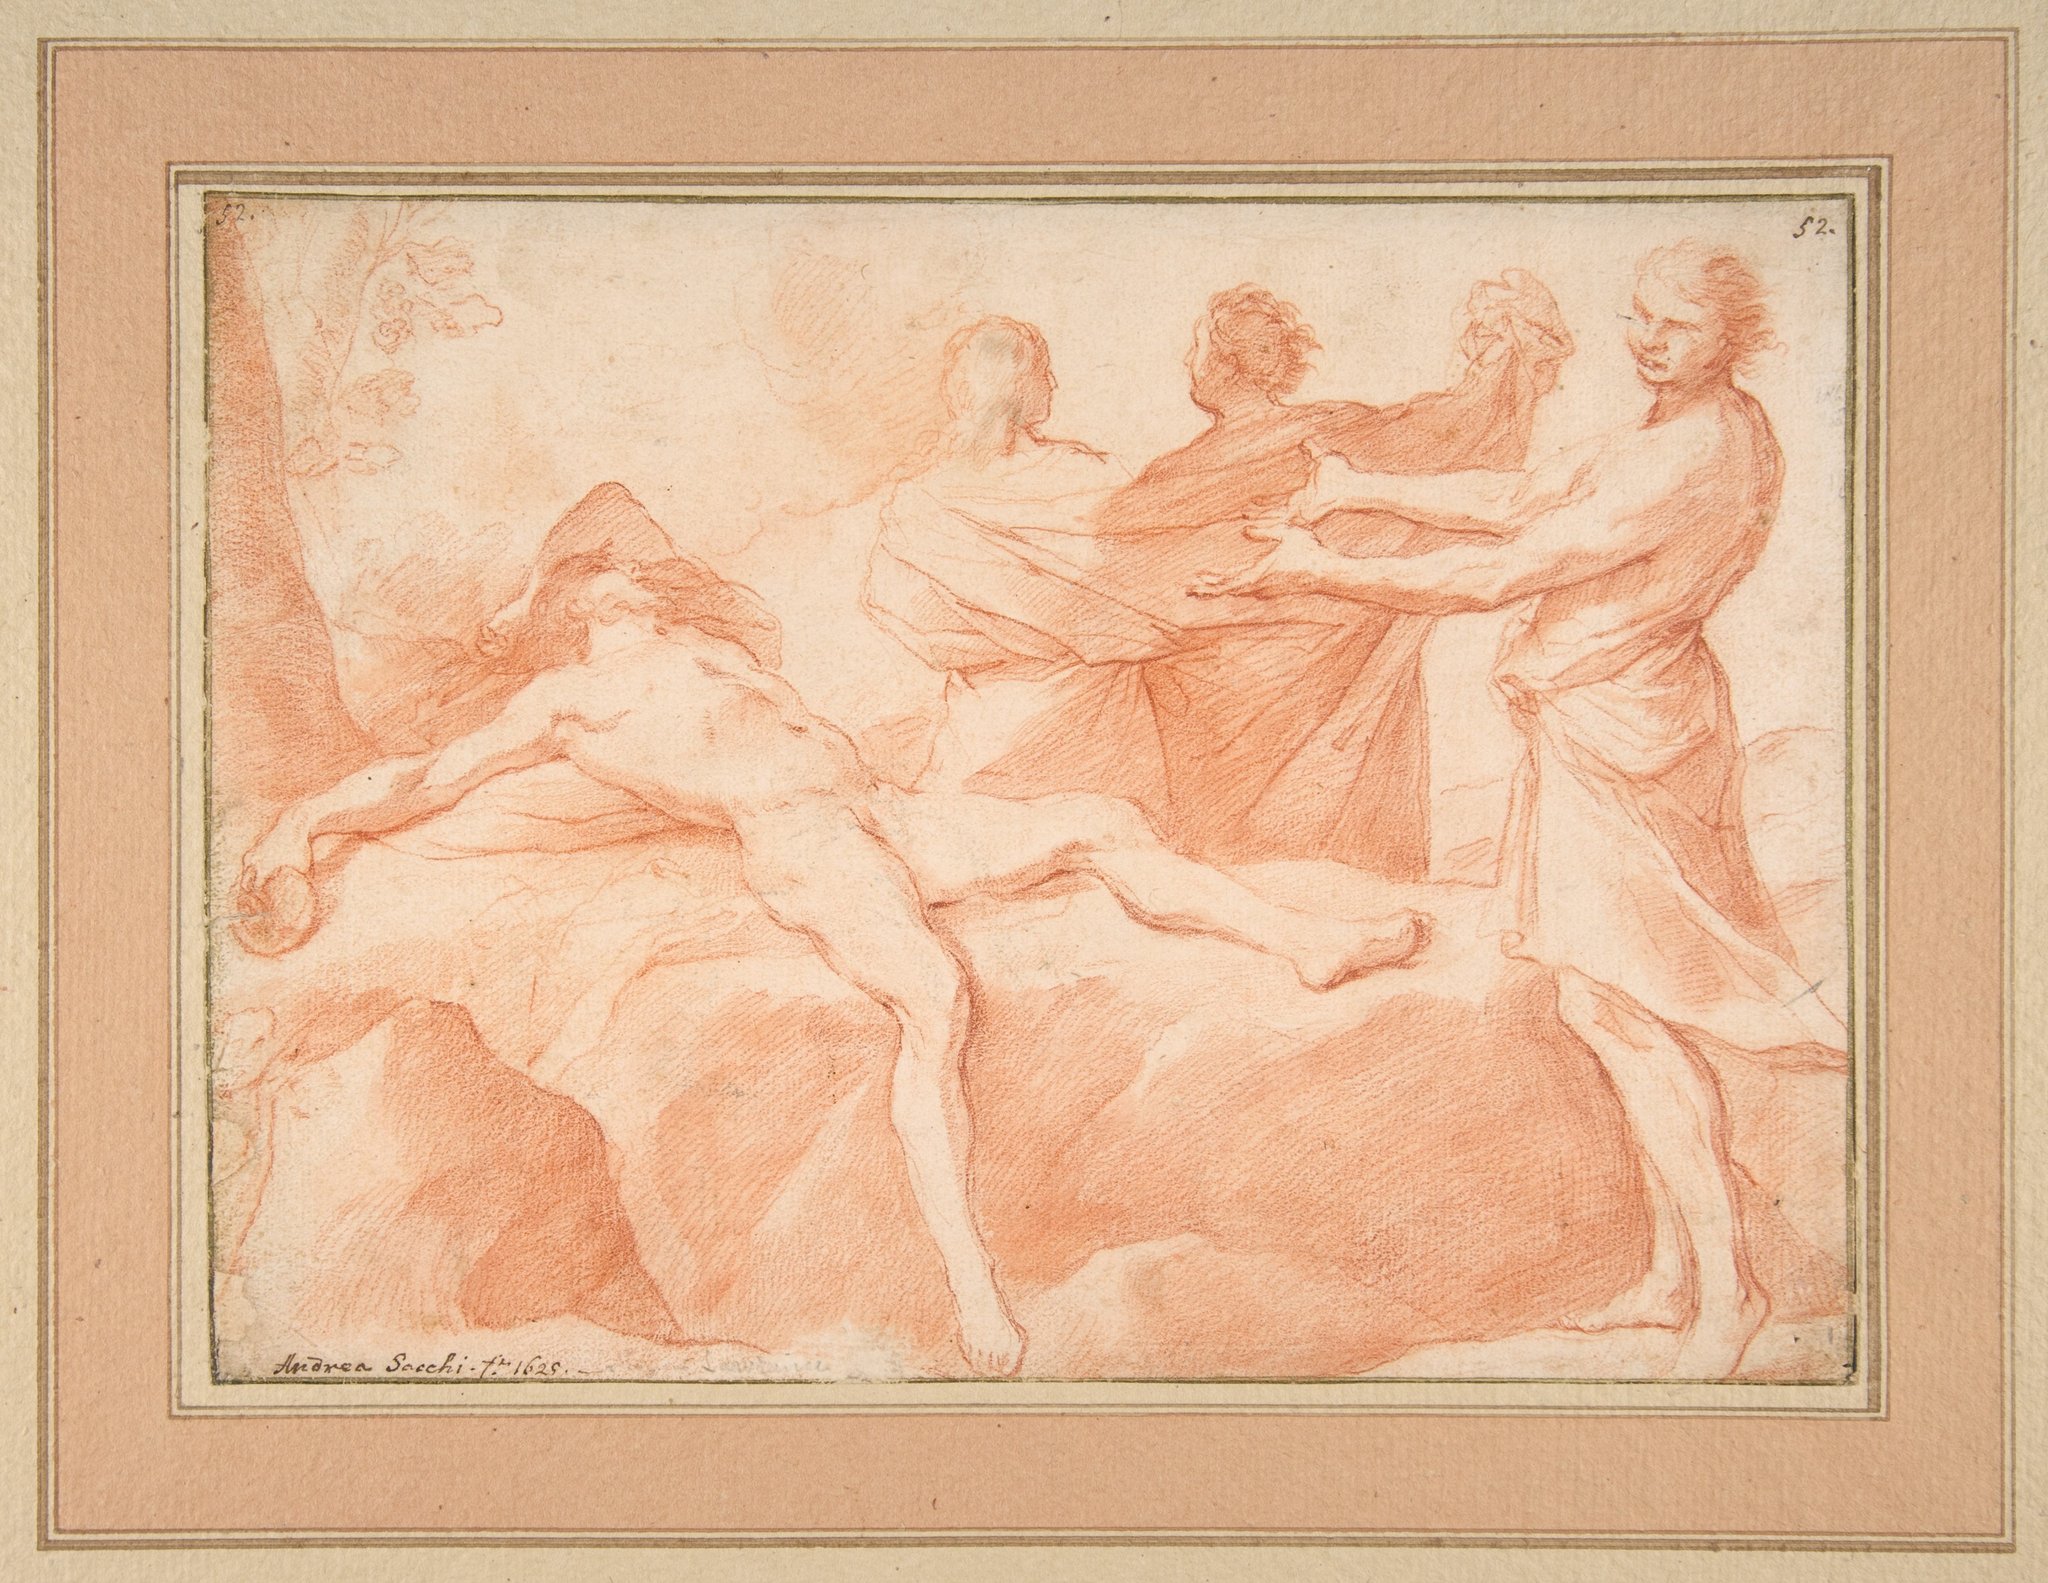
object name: drawing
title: The Drunkenness of Noah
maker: andrea sacchi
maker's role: artist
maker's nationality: italian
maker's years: 1599-1661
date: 1599-1661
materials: chalk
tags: drunkenness,men,male nudes,women